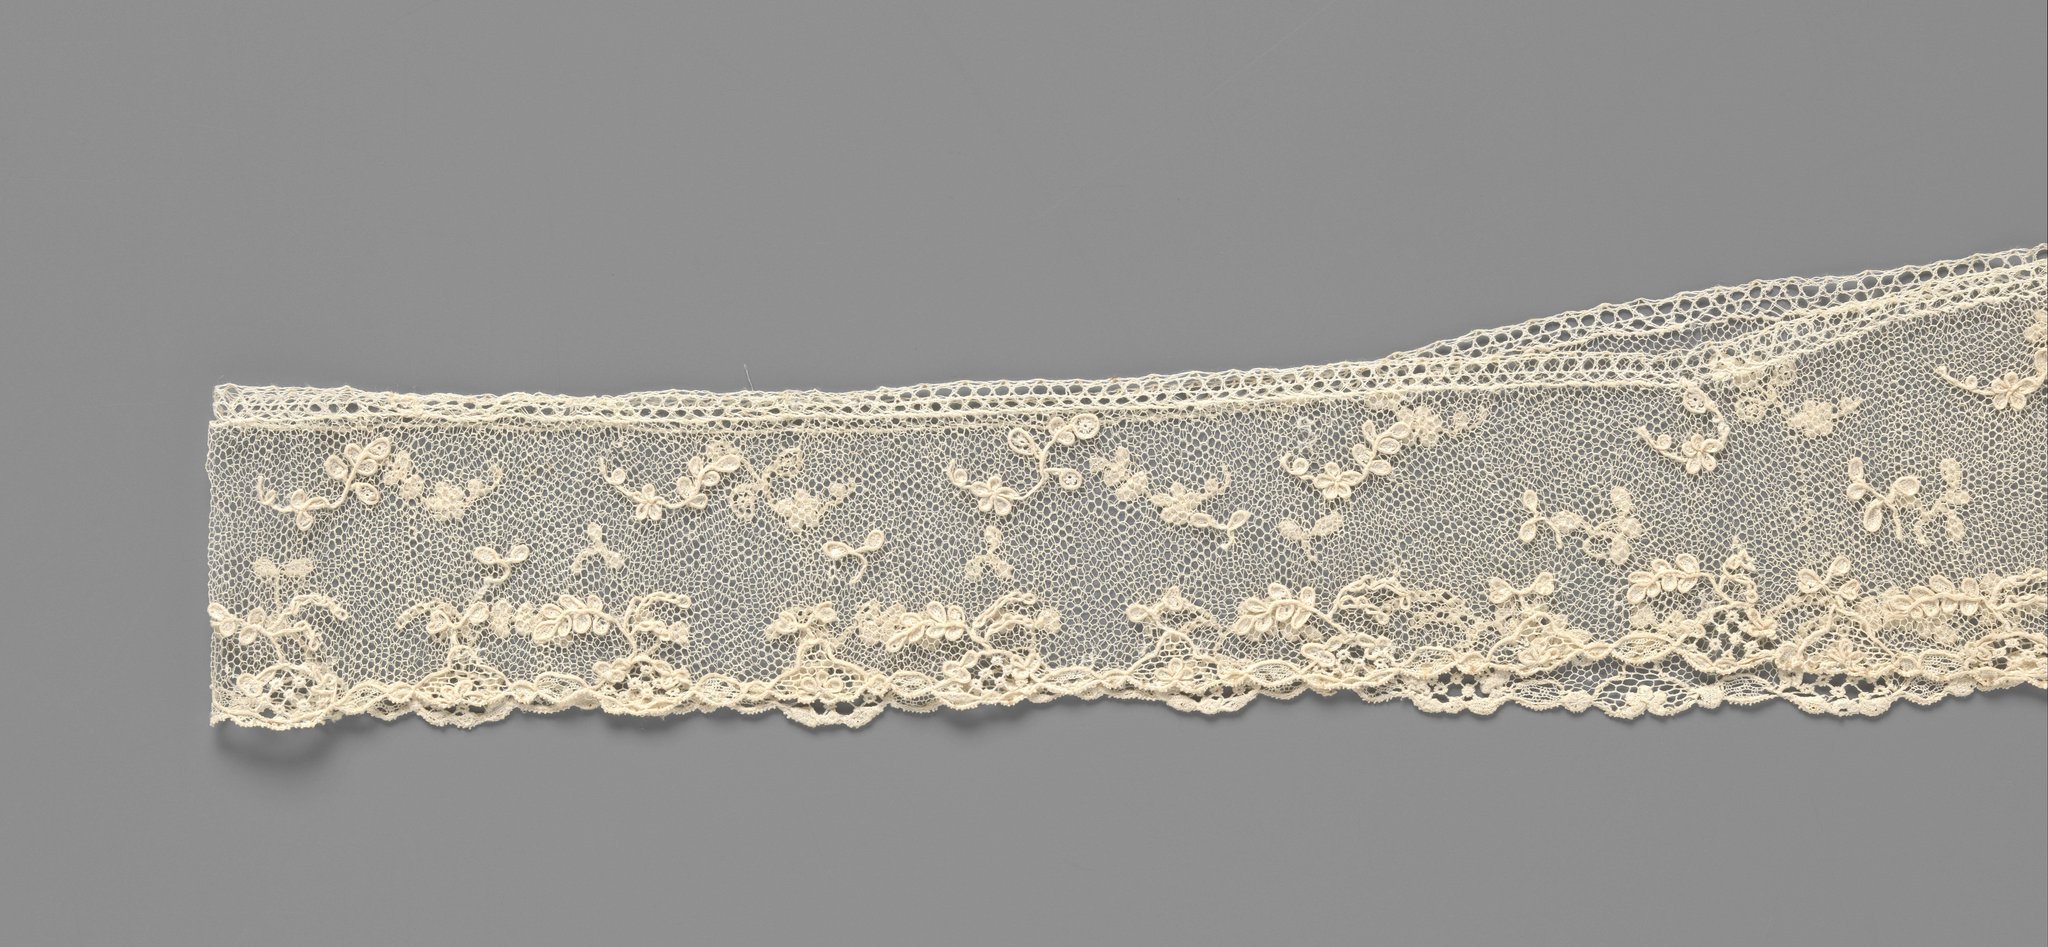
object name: engageante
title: Engageante van naaldkant met strooibloemen en opengewerkte bloempjes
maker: Anonymous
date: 1775-1799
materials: linen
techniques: lace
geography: france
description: Engageante van naturelkleurige naaldkant: Alençon-kant. Het patroon heeft strooibloemen op een grond van gedraaide (vierkante) mazen en een rankenrand met diverse vullingen siergrondjes en siersteken waaronder grondjes in diamantsteek en rasterwerk met radarpicots. Bijzonder zijn de opengewerkte bloempjes, die sporadisch op deze manier in Alençon-kant voorkomen. De motiefjes zijn opgebouwd uit festonsteken en voorzien van gefestonneerde reliëfcontouren. De bovenzijde is recht afgewerkt met een geklost bandje. De zeer vlakke schulpenrand is afgewerkt met picots. De uiteinden zijn haast onzichtbaar aan elkaar gezet.